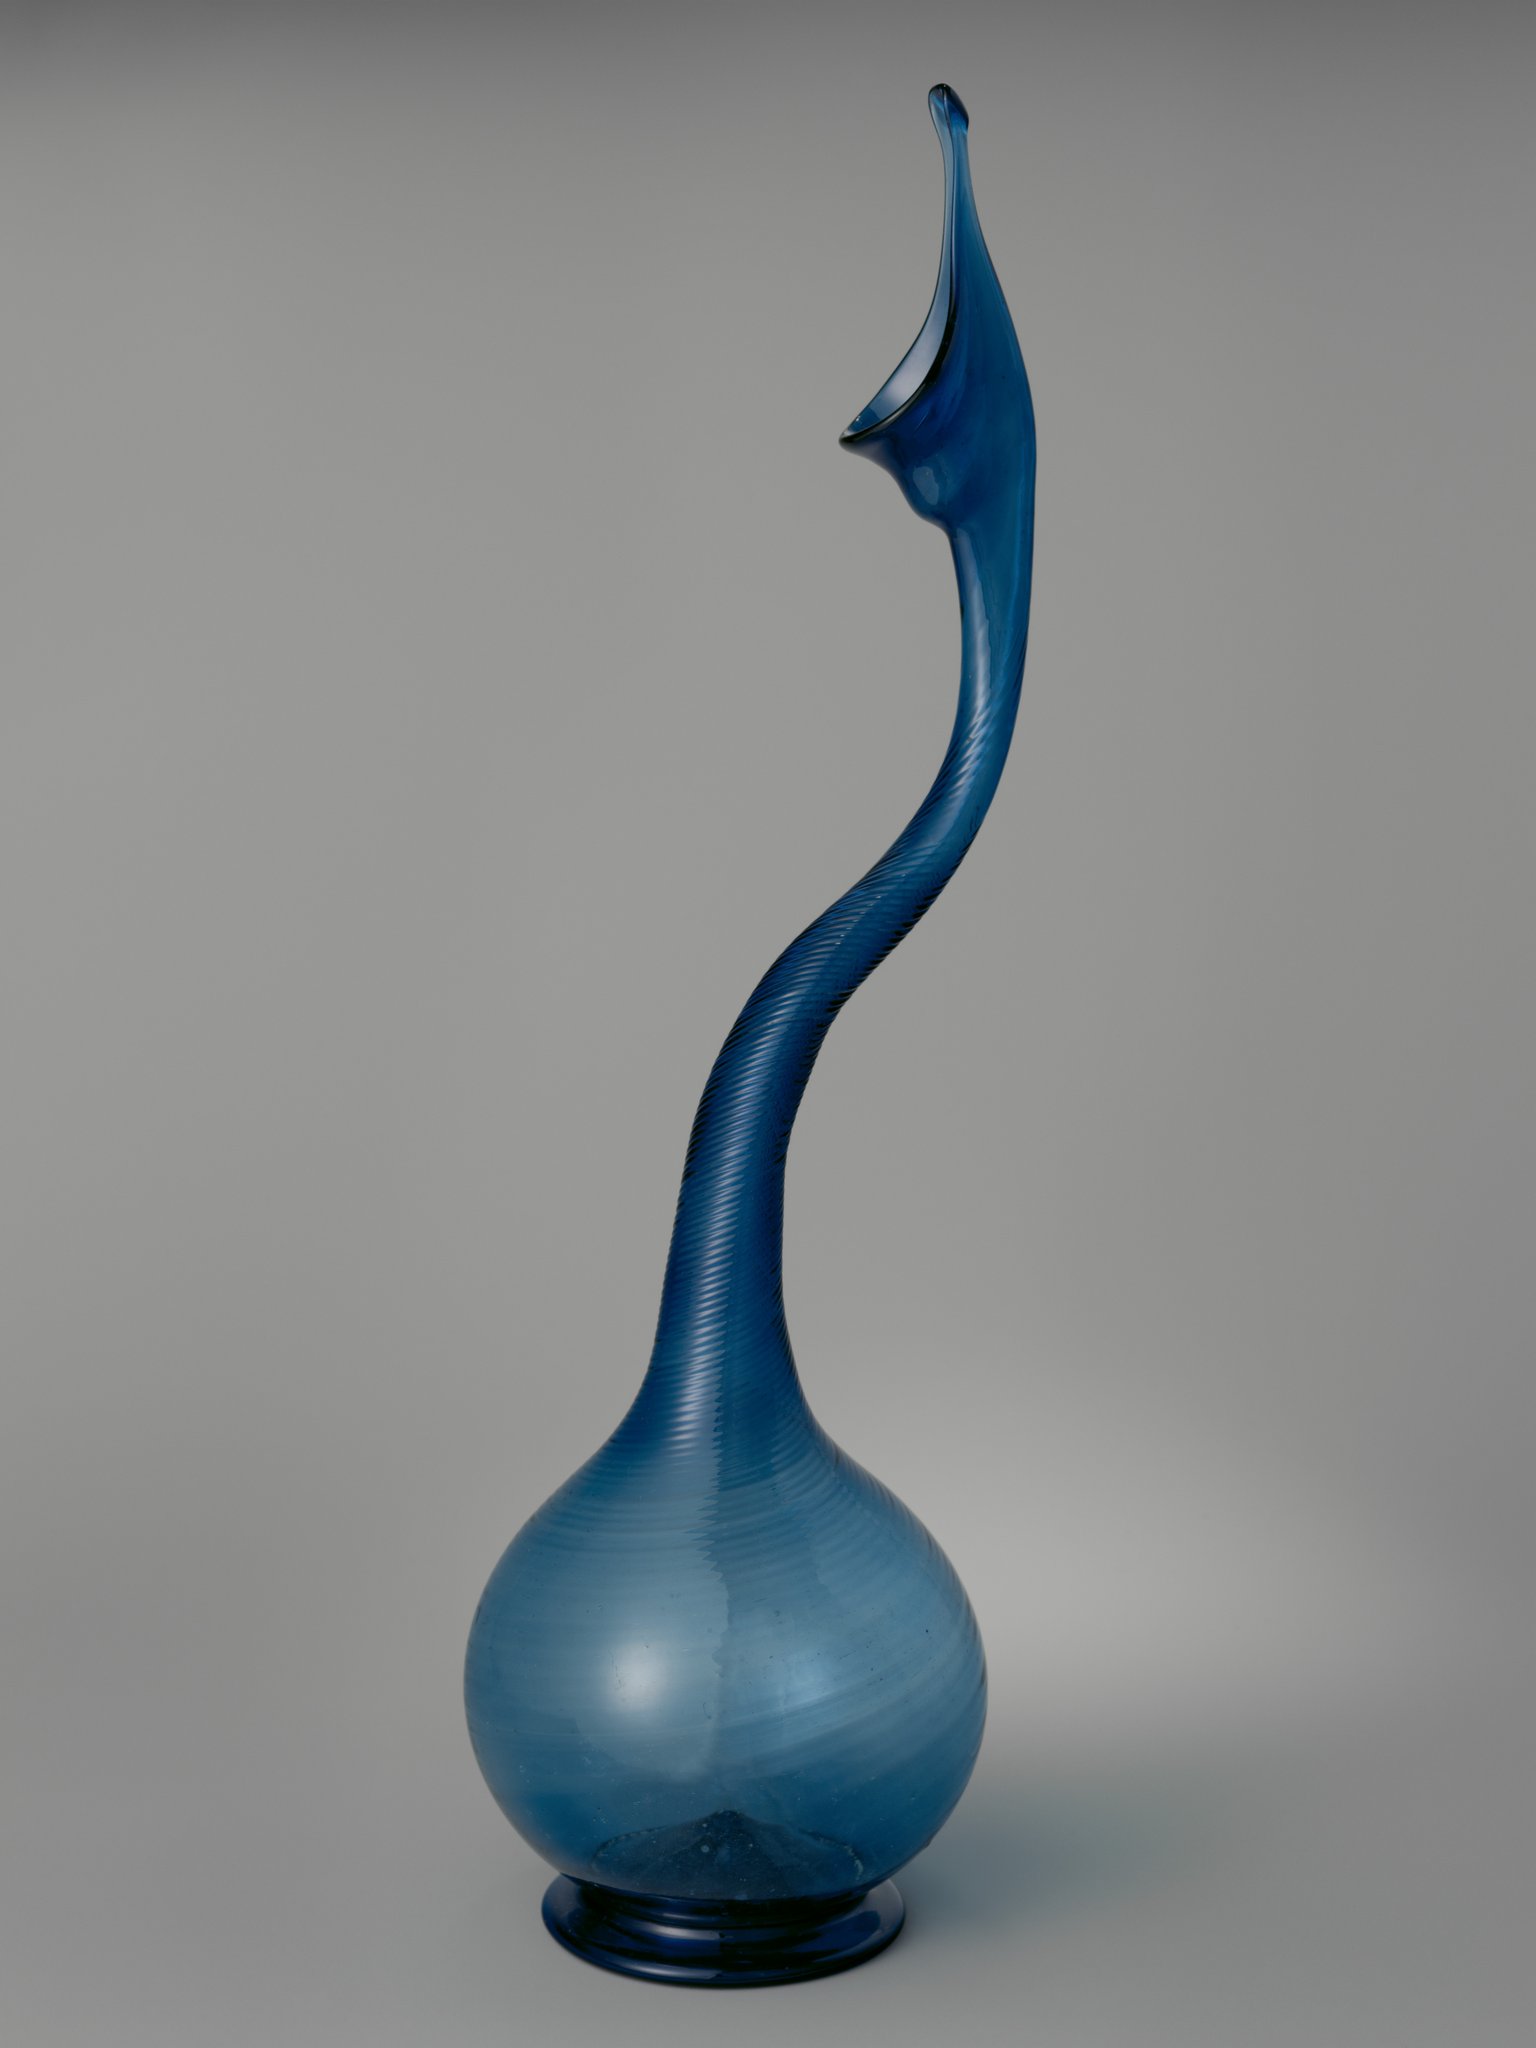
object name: bottle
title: Swan-Neck Bottle (Ashkdan)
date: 1801-1900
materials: glass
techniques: glassblowing, tooling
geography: iran